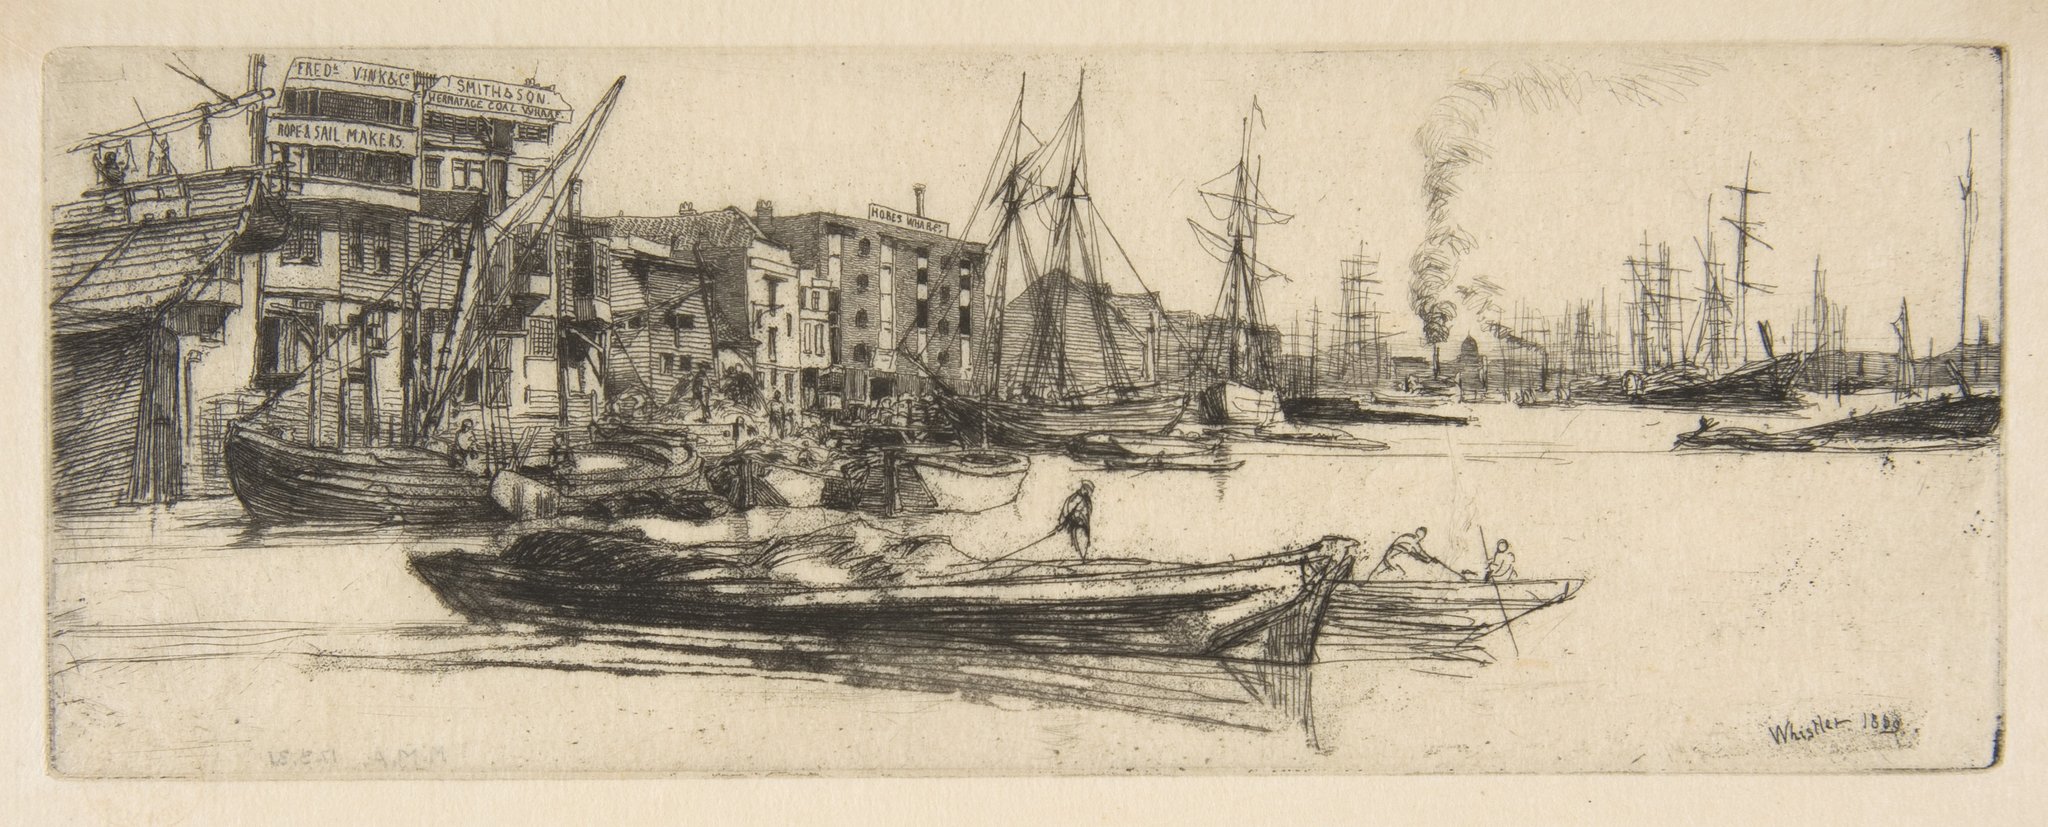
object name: print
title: Thames Warehouses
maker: james mcneill whistler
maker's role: artist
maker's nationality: american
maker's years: 1834-1903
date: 1859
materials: ink, paper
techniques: drypoint, etching, printing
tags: warehouses,rivers,boats